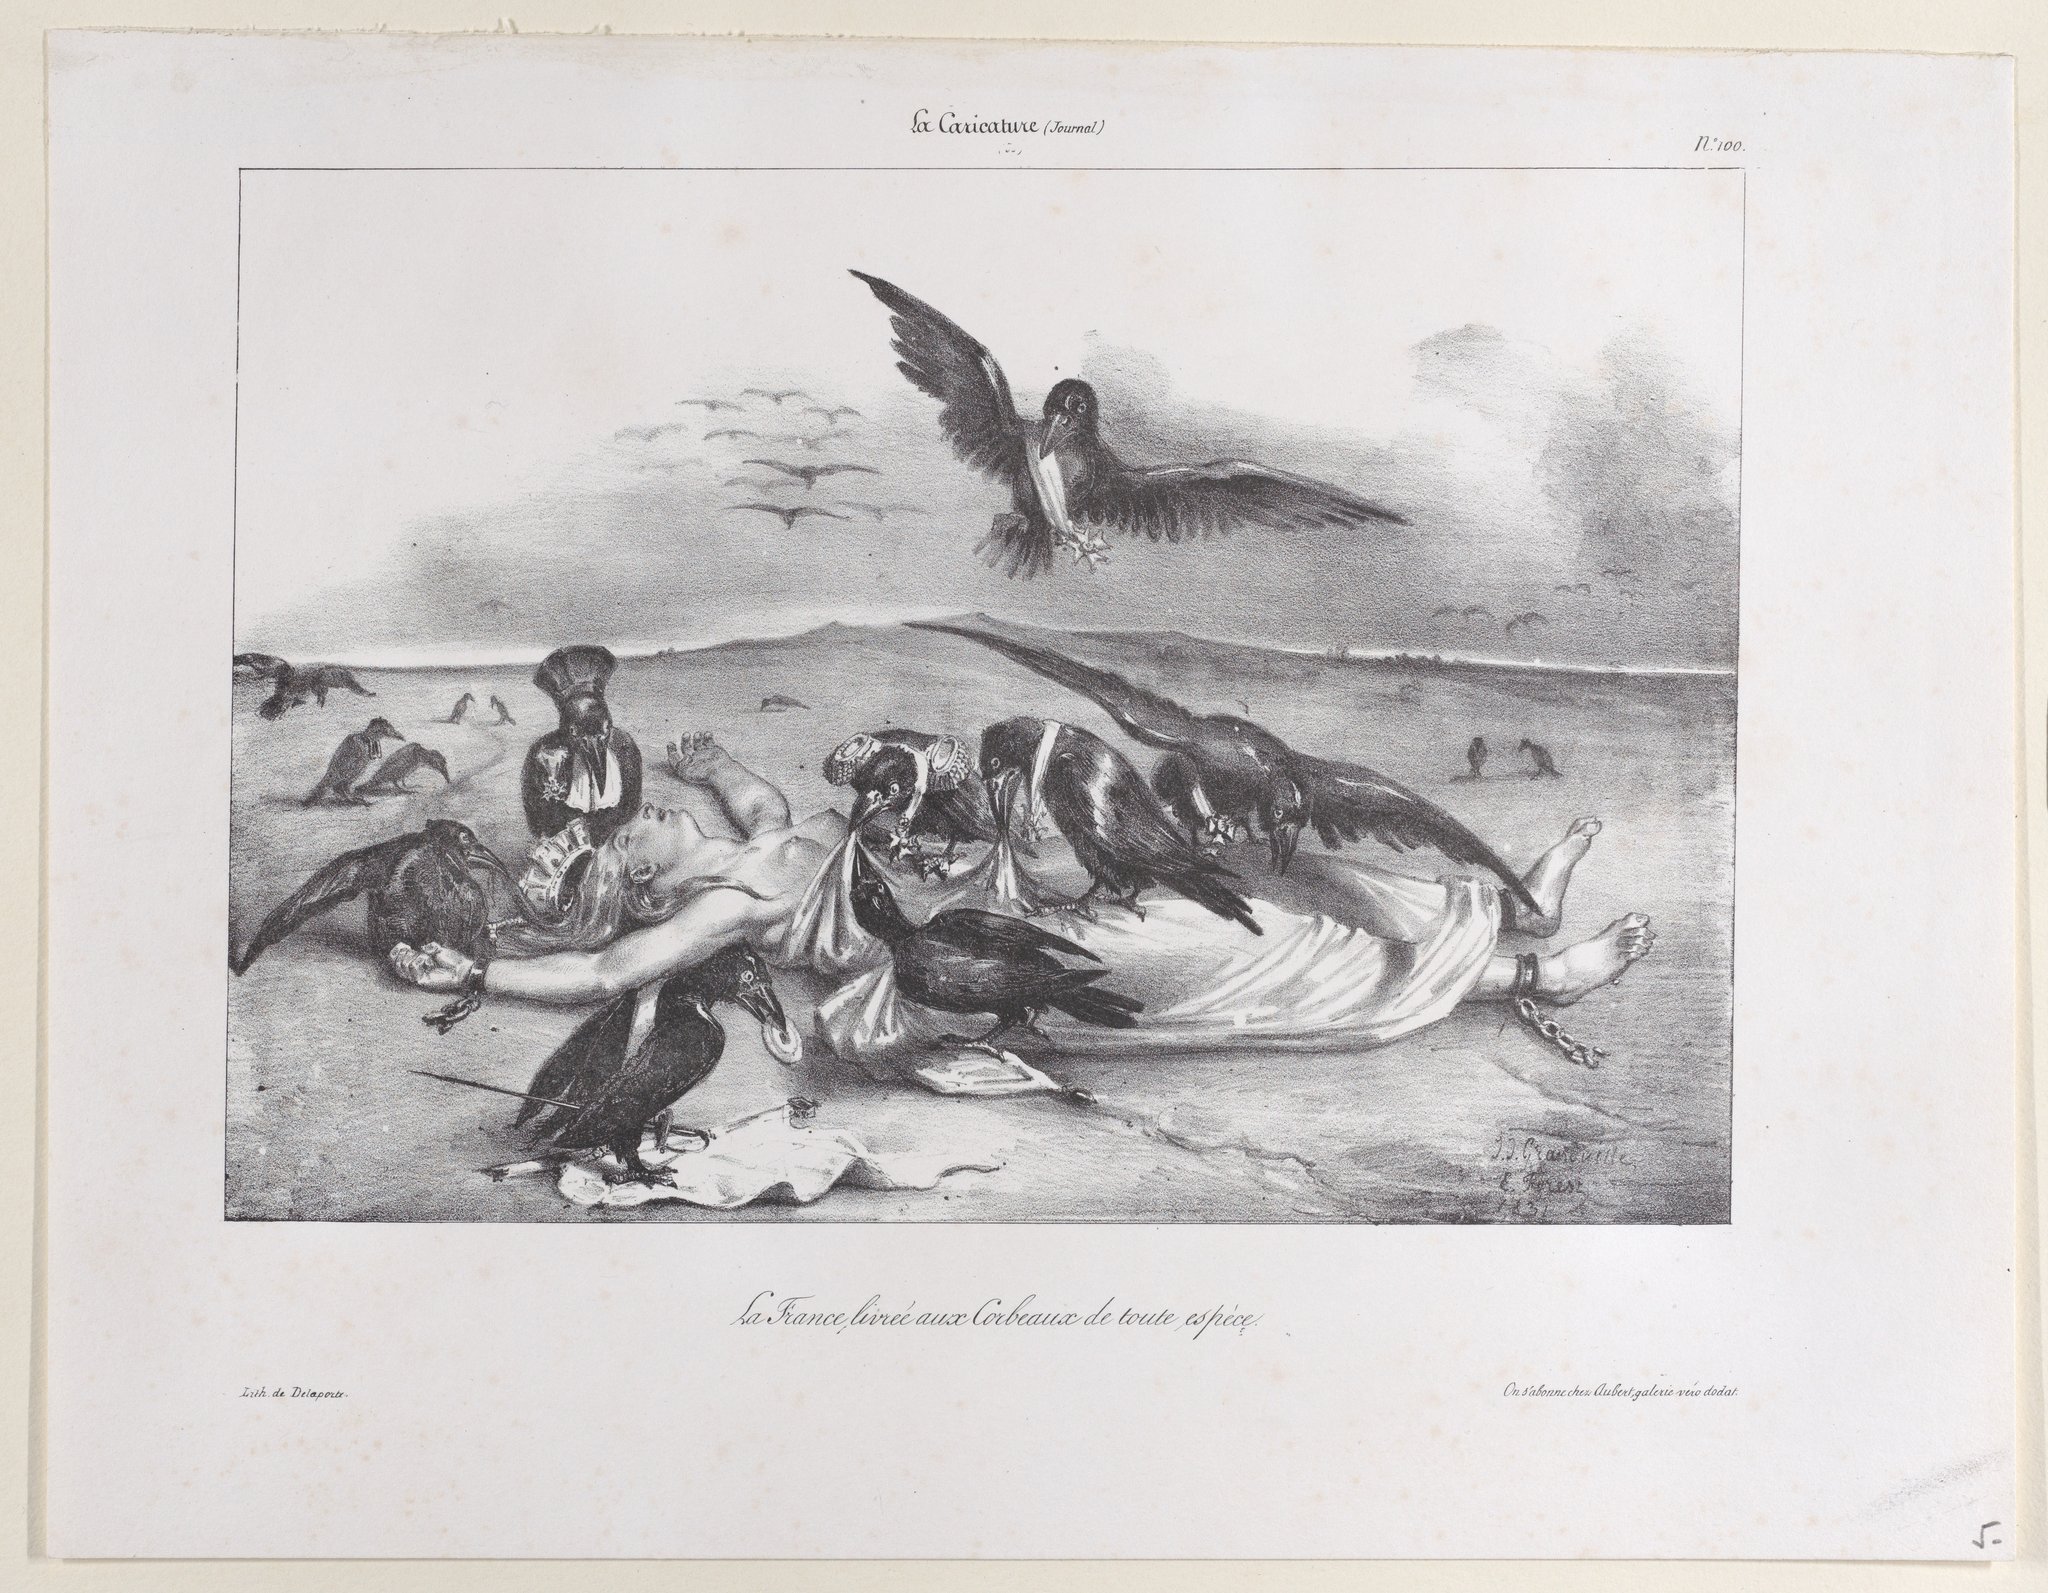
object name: print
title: France Delivered to the Crows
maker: j. j. grandville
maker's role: artist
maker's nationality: french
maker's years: 1803-1847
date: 1831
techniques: lithograph